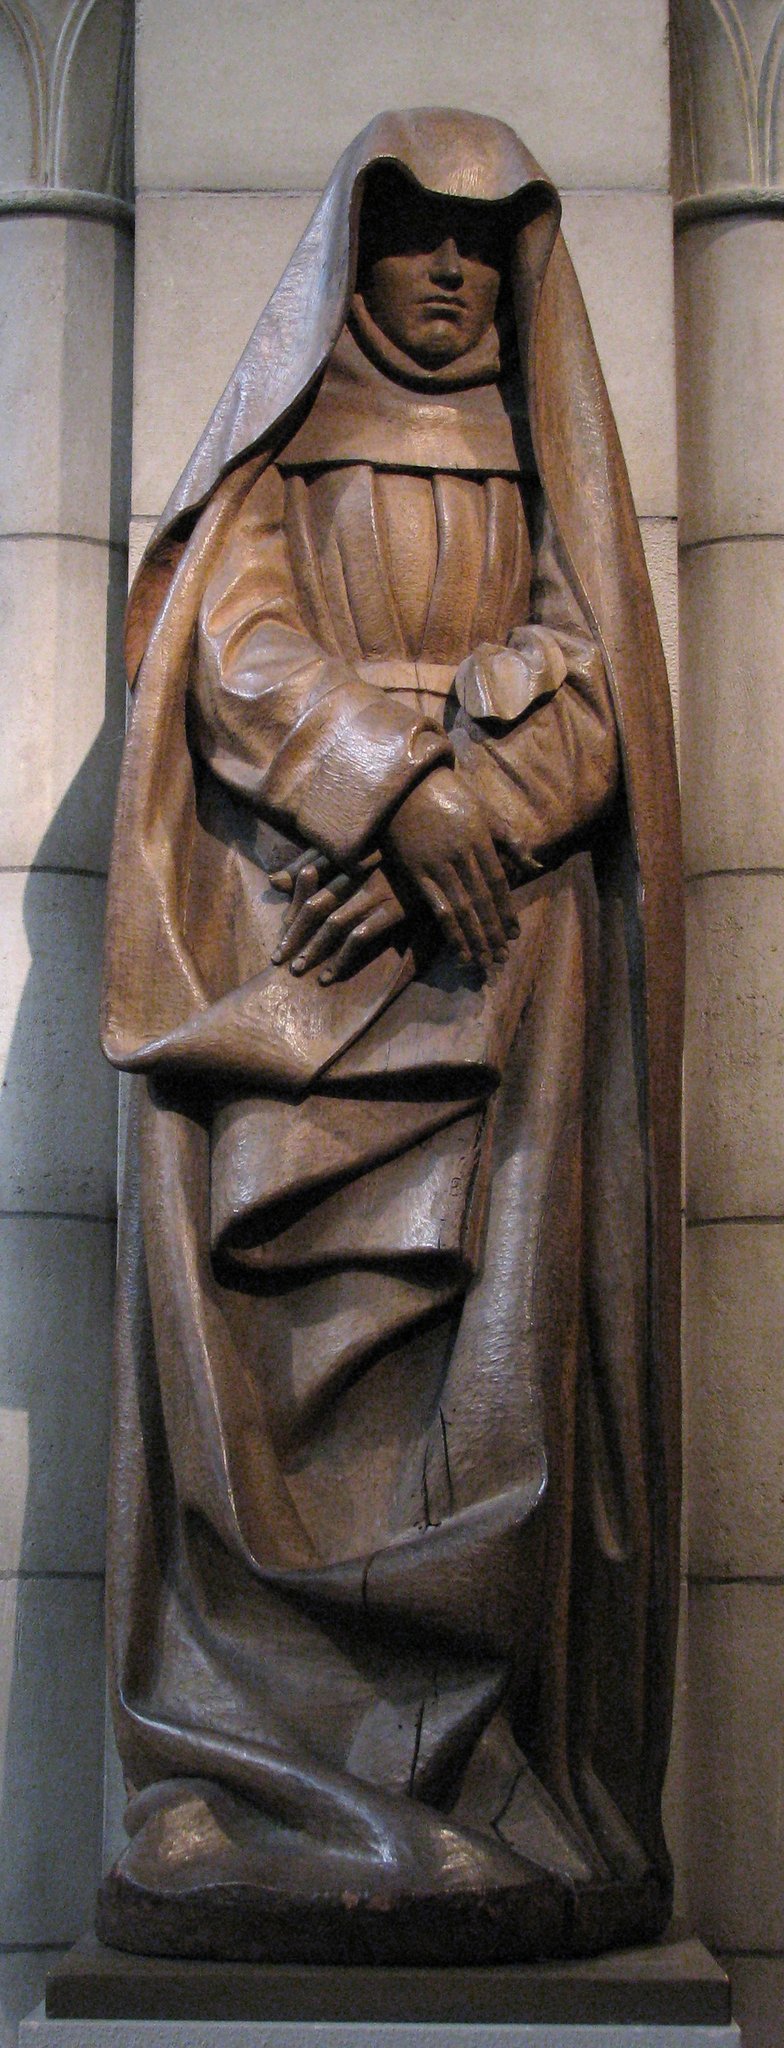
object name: wall statue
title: Mourning Virgin from a Crucifixion Group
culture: french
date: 1450-1475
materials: paint, wood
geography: france